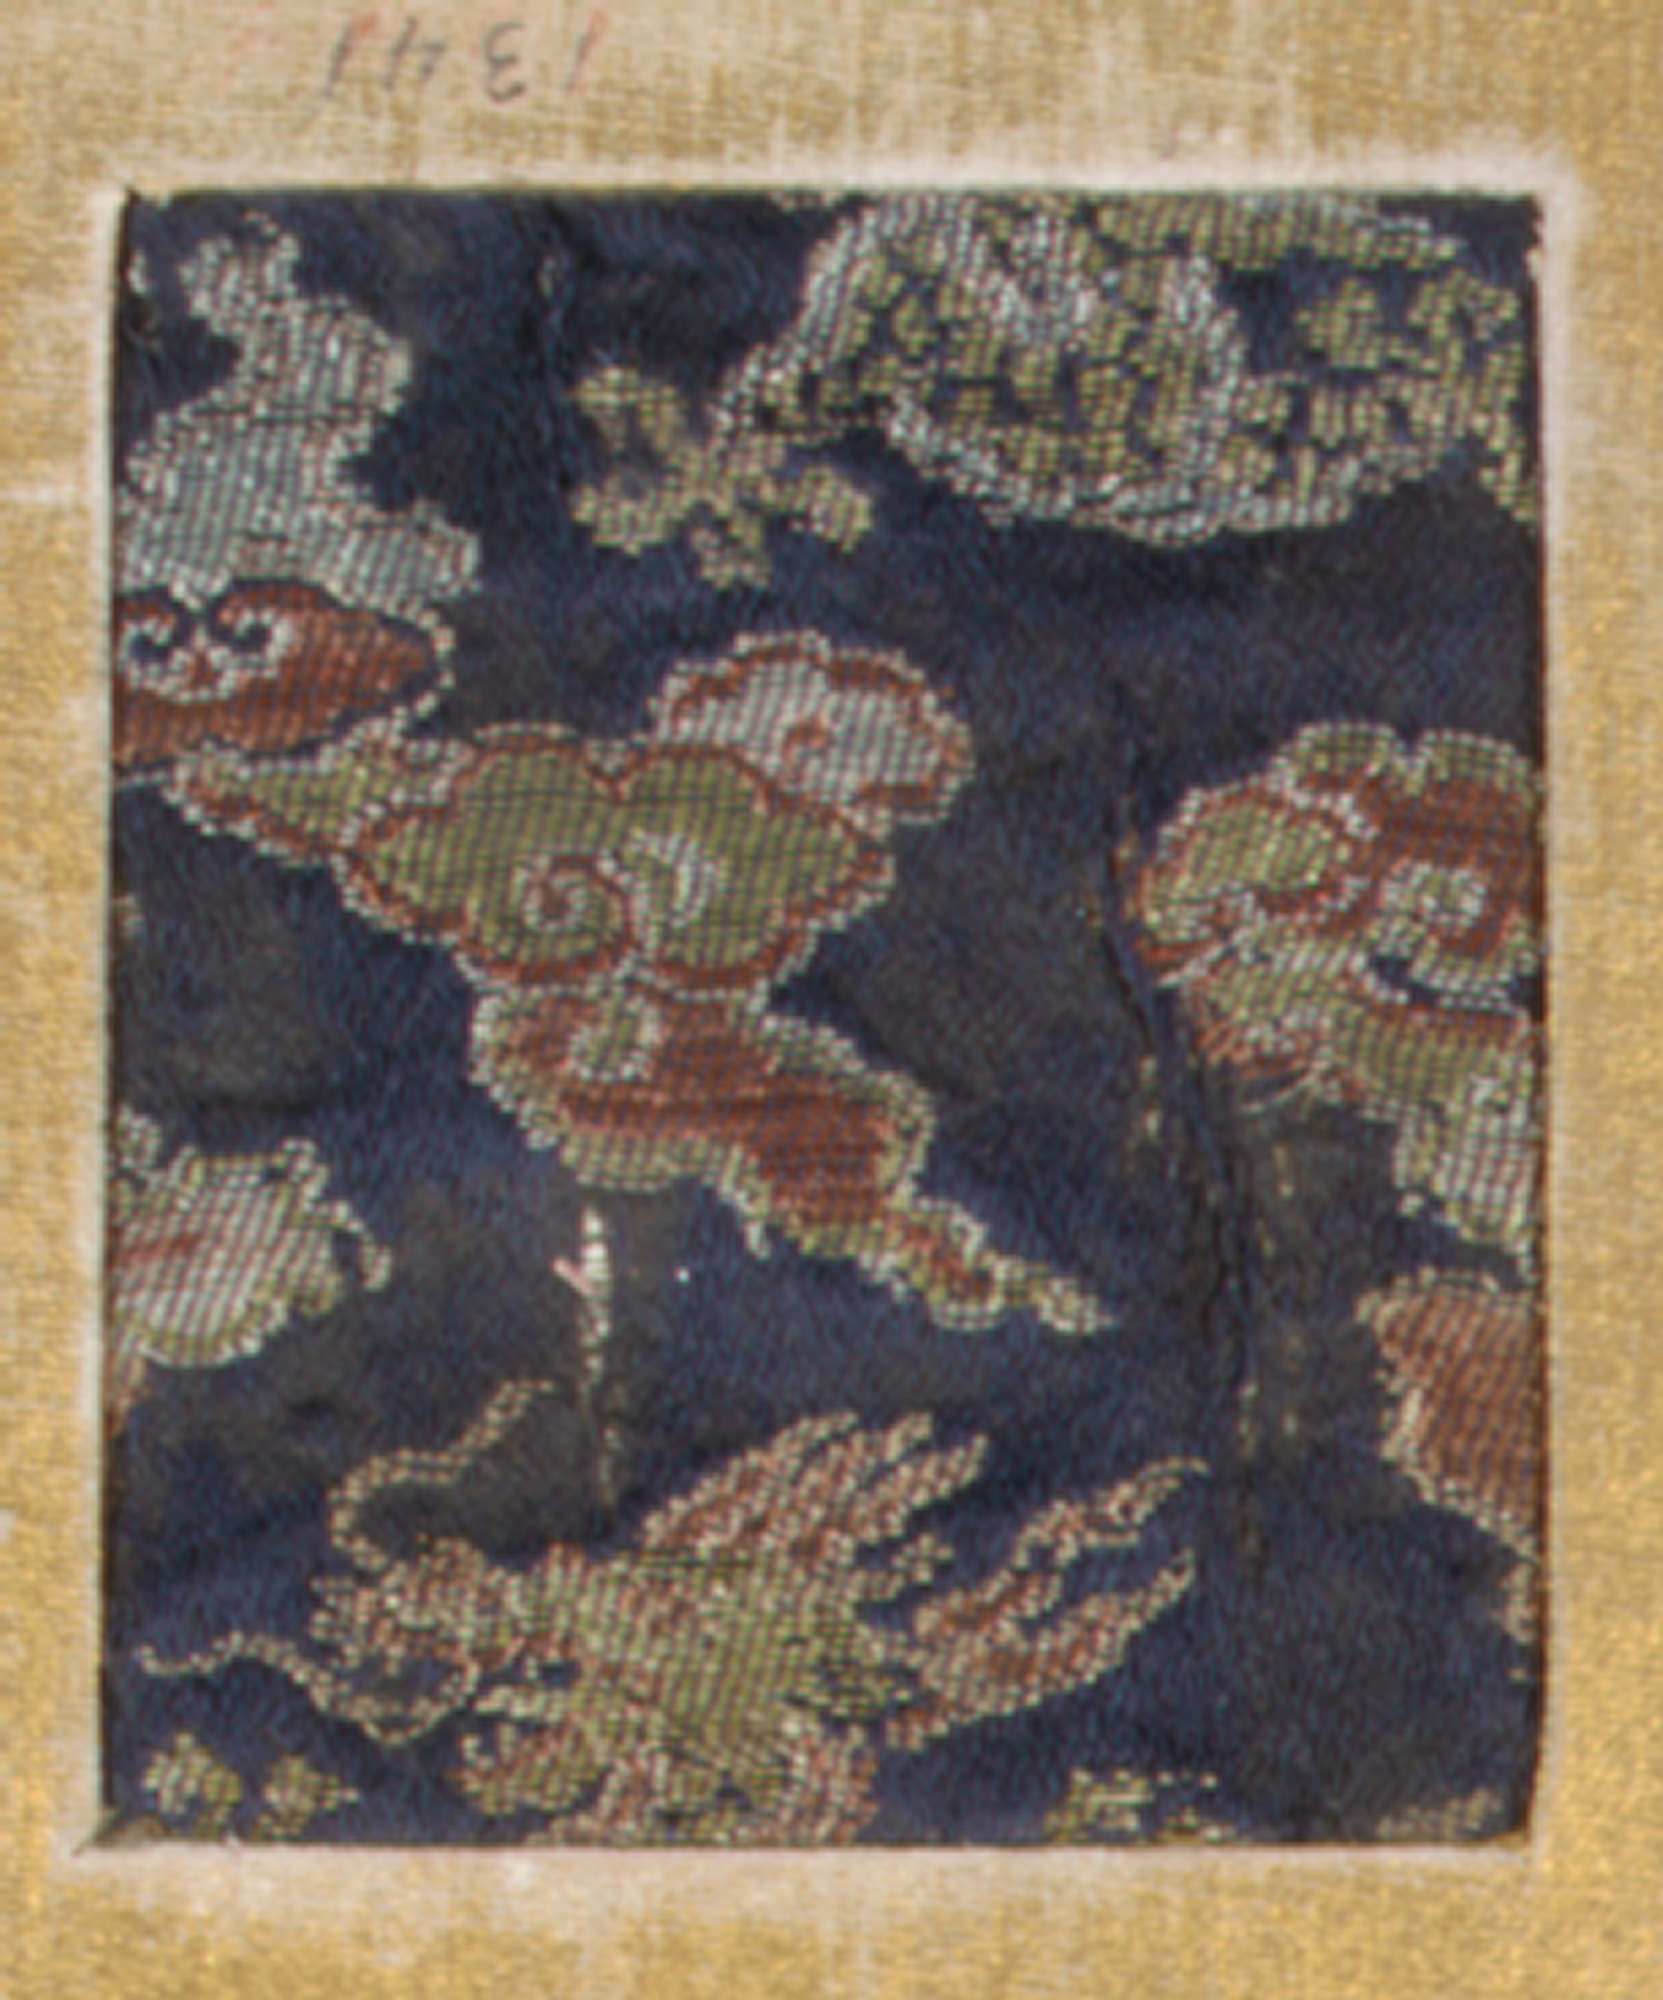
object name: piece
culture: japanese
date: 1701-1900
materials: silk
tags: dragons